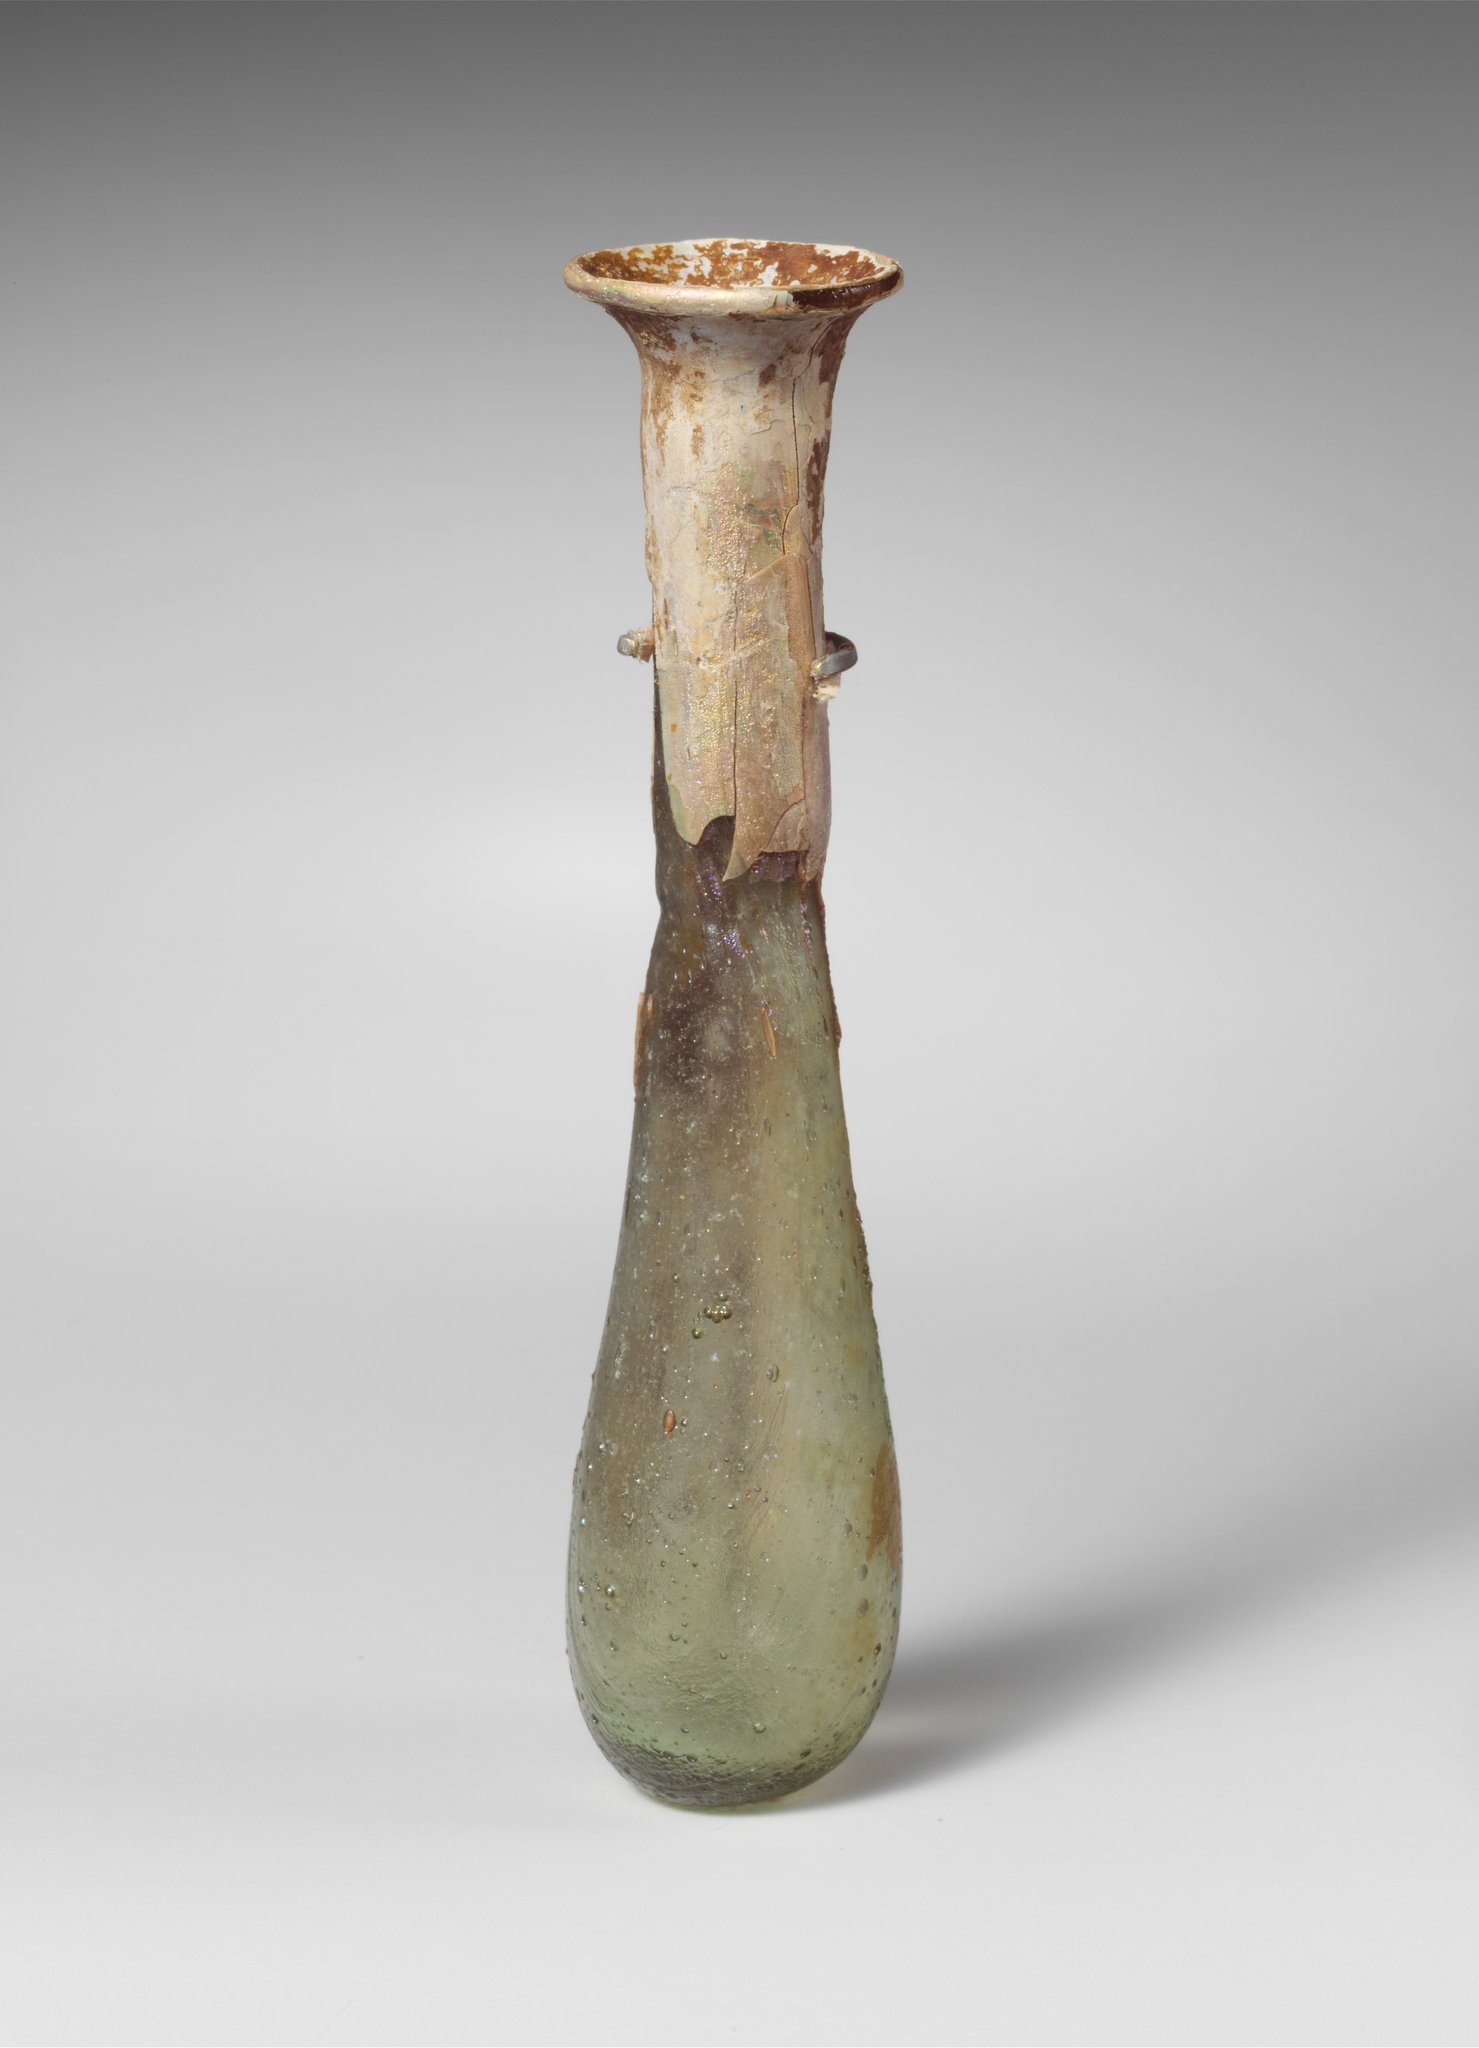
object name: perfume bottle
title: Glass perfume bottle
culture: roman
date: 1-200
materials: glass